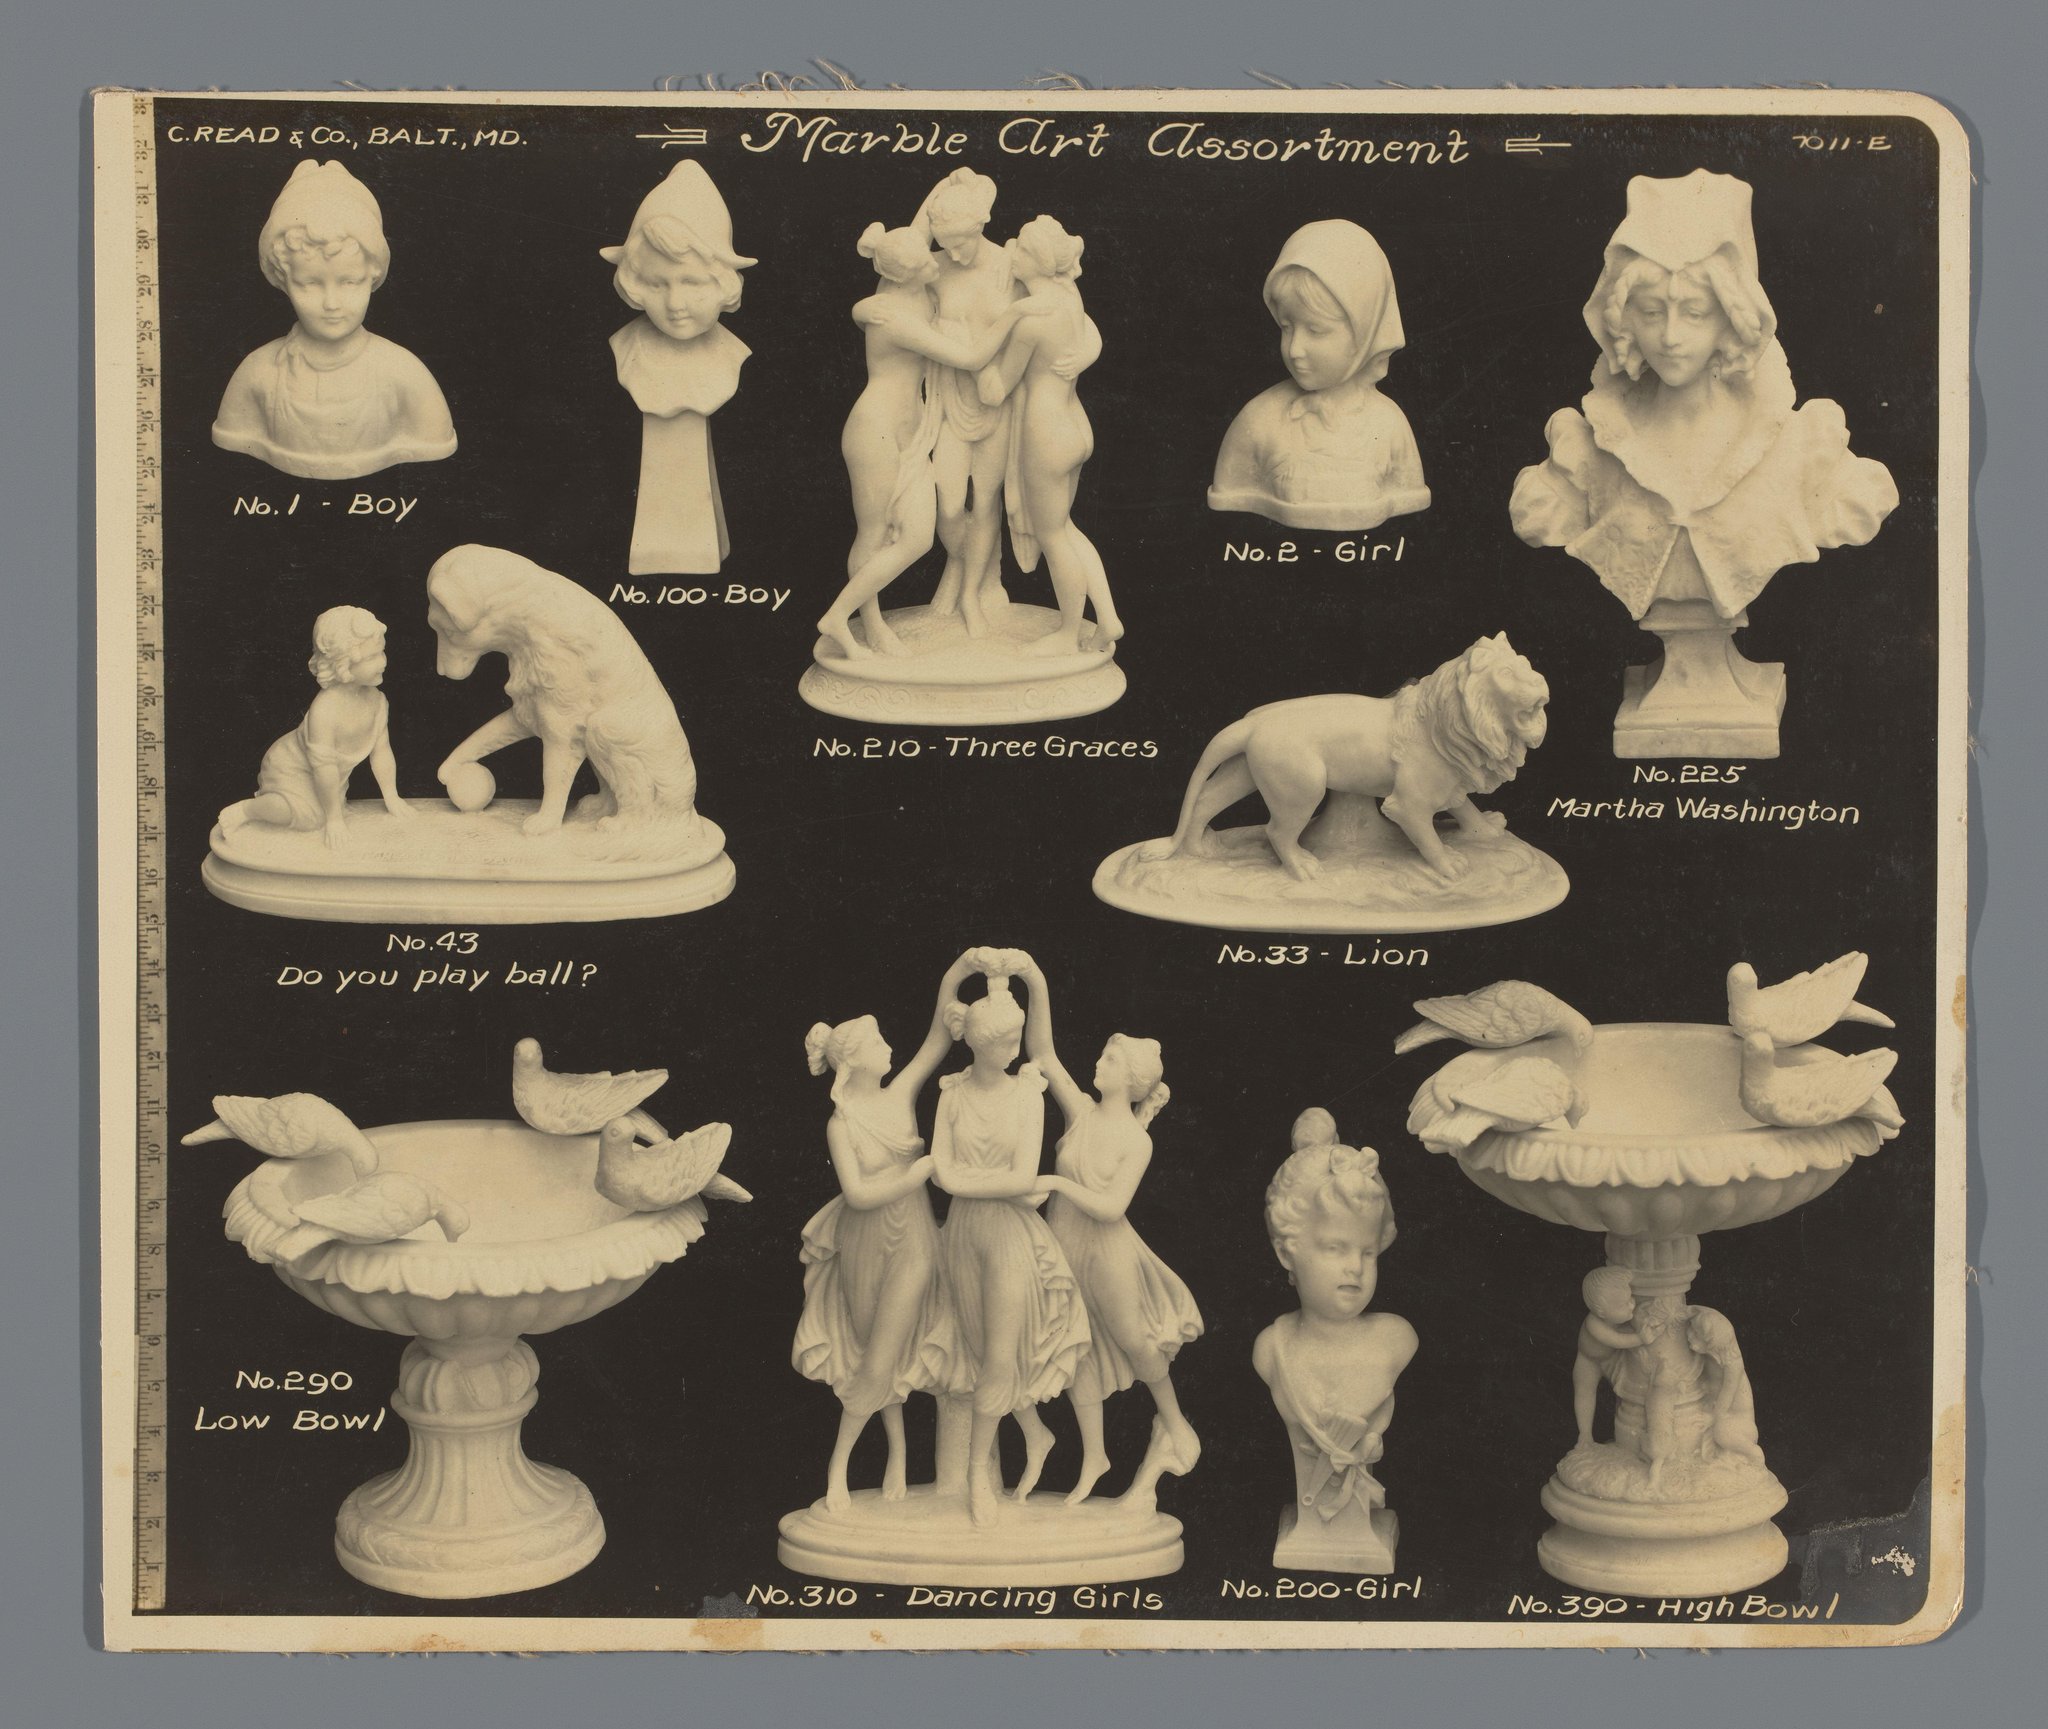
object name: photograph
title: Reclamefoto met serviezen en keukengerei van de firma C. Read & Co., Baltimore, Maryland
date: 1920-1930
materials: paper, textile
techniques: photography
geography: united states